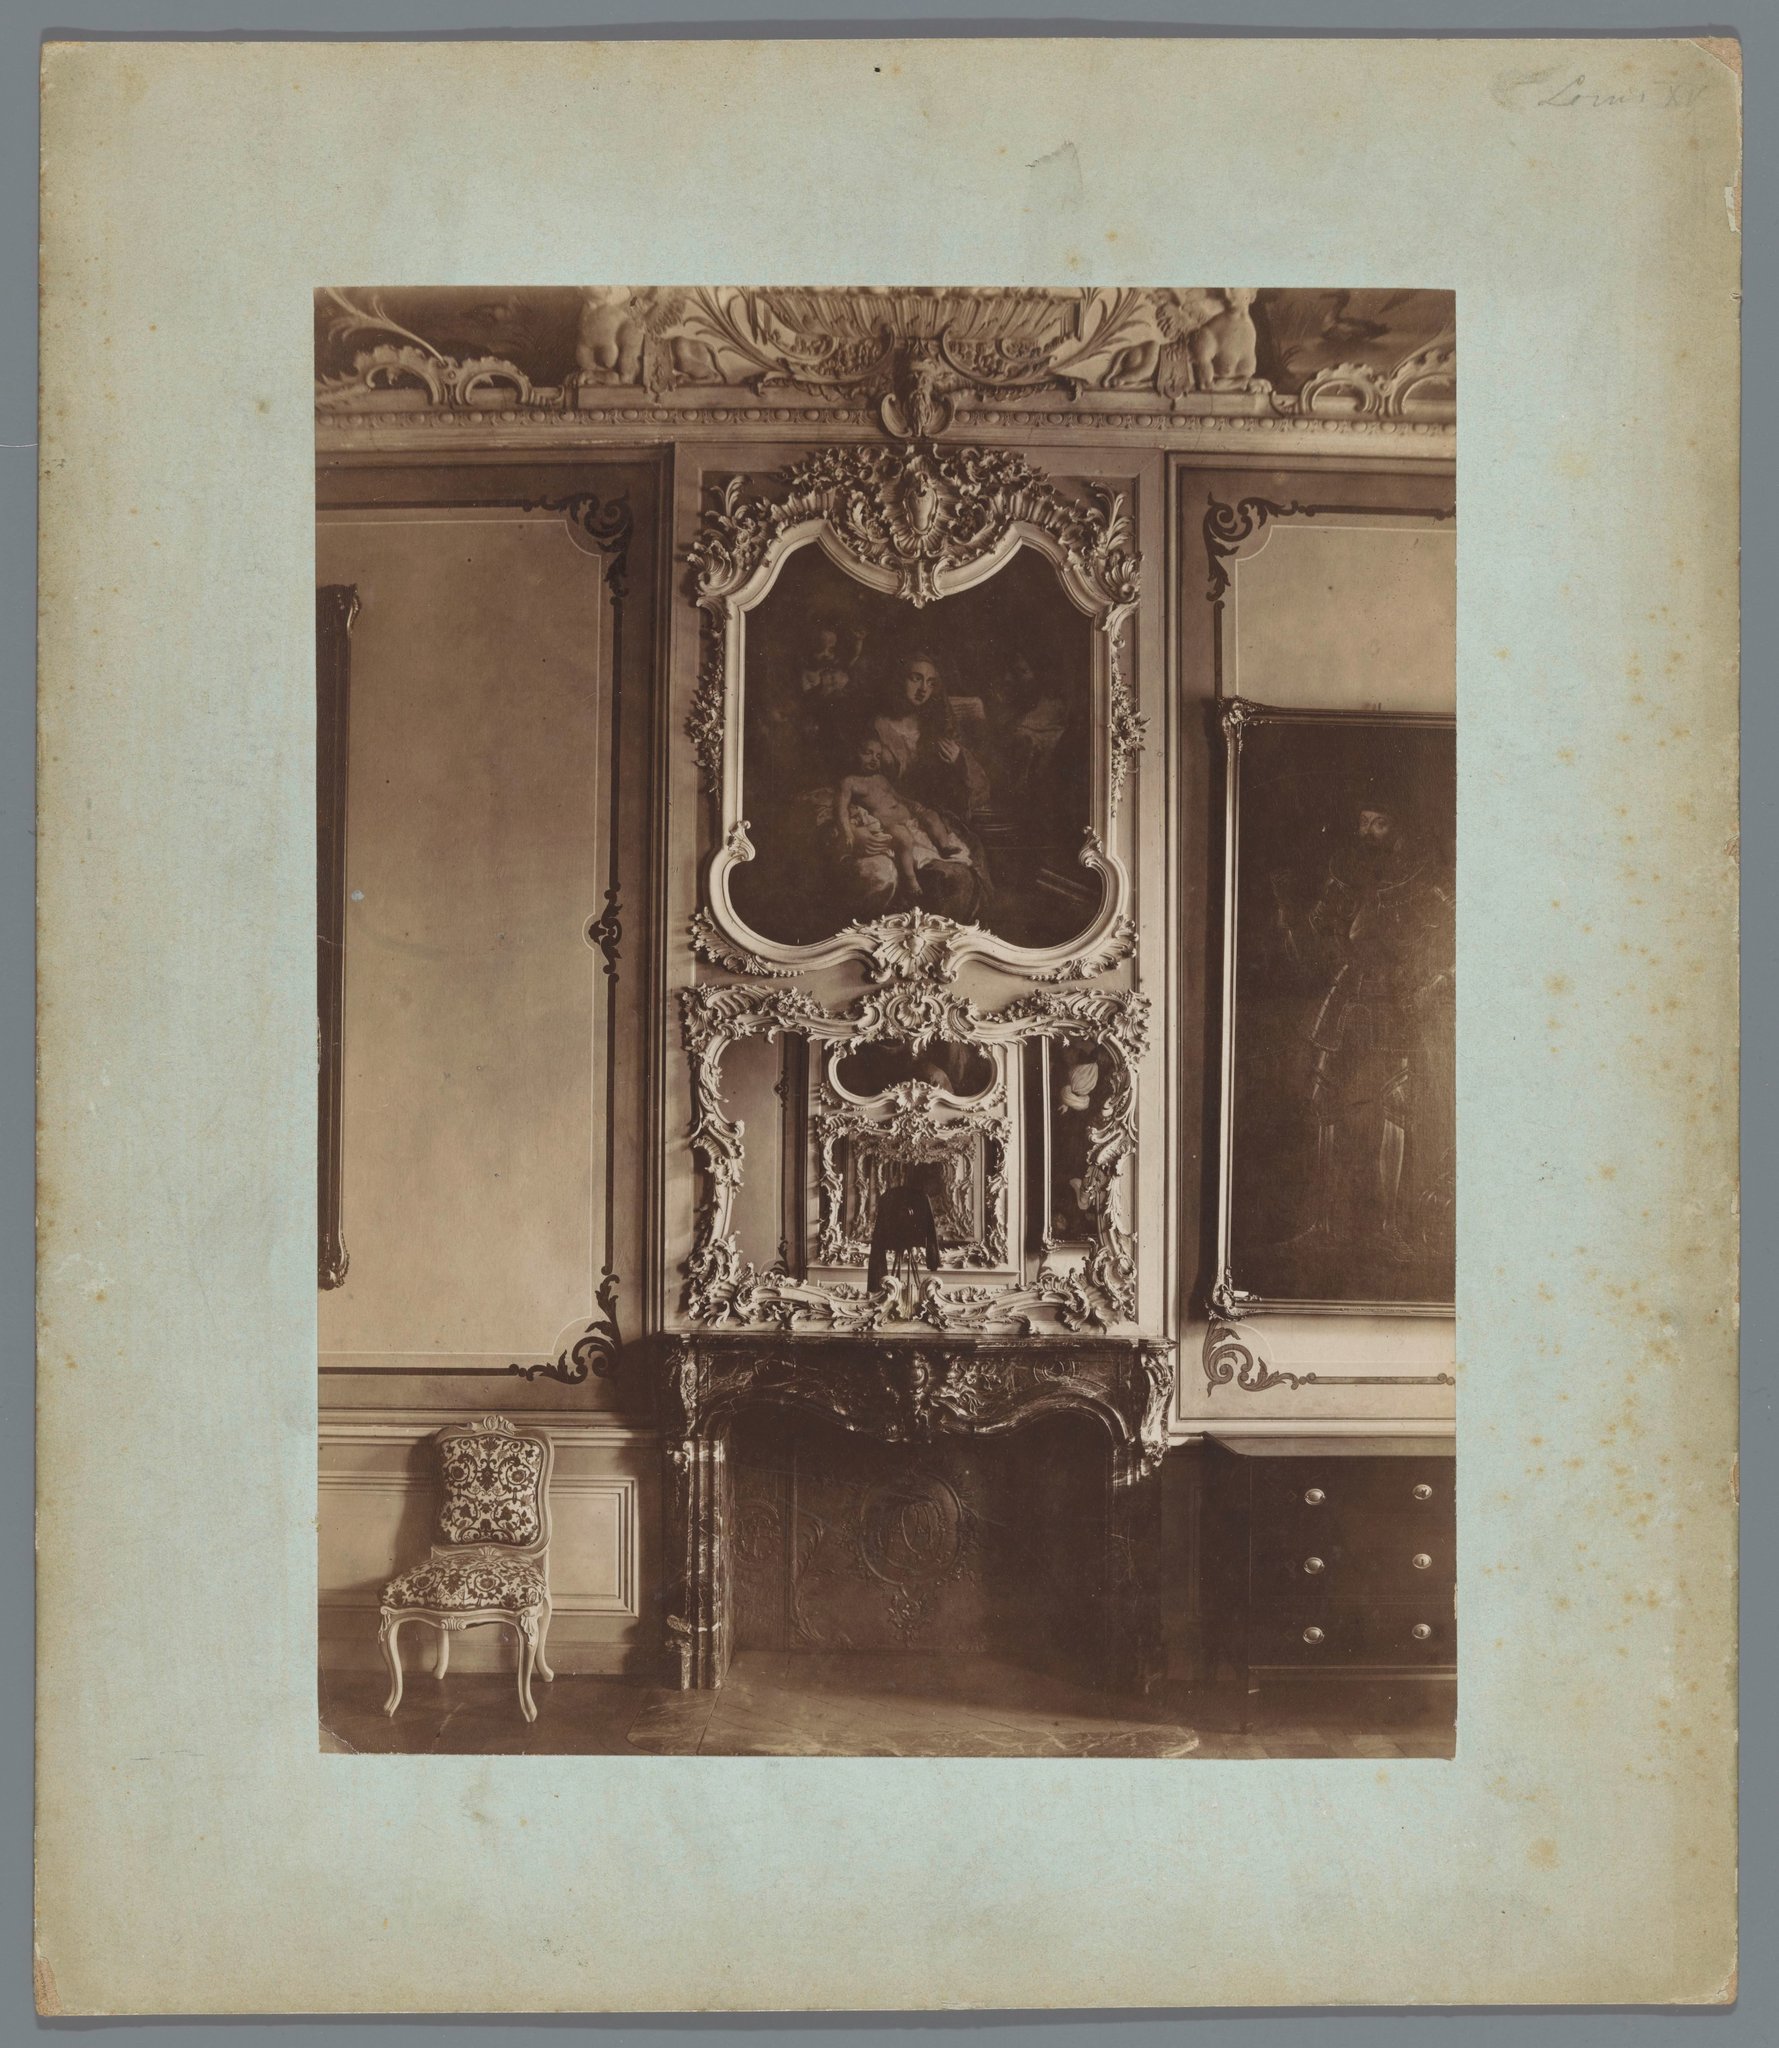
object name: photograph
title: Interieur met een schouw, een spiegel en schilderijen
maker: Anonymous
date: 1875-1900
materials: cardboard, photographic support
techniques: albumen print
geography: europe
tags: camera ~ photography, mirror, open hearth, fire-place, interior ~ representation of a building, europe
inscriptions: collector's mark: Lugt 3937, inscription: ‘Louis XV’, inscription: ‘pl 1’